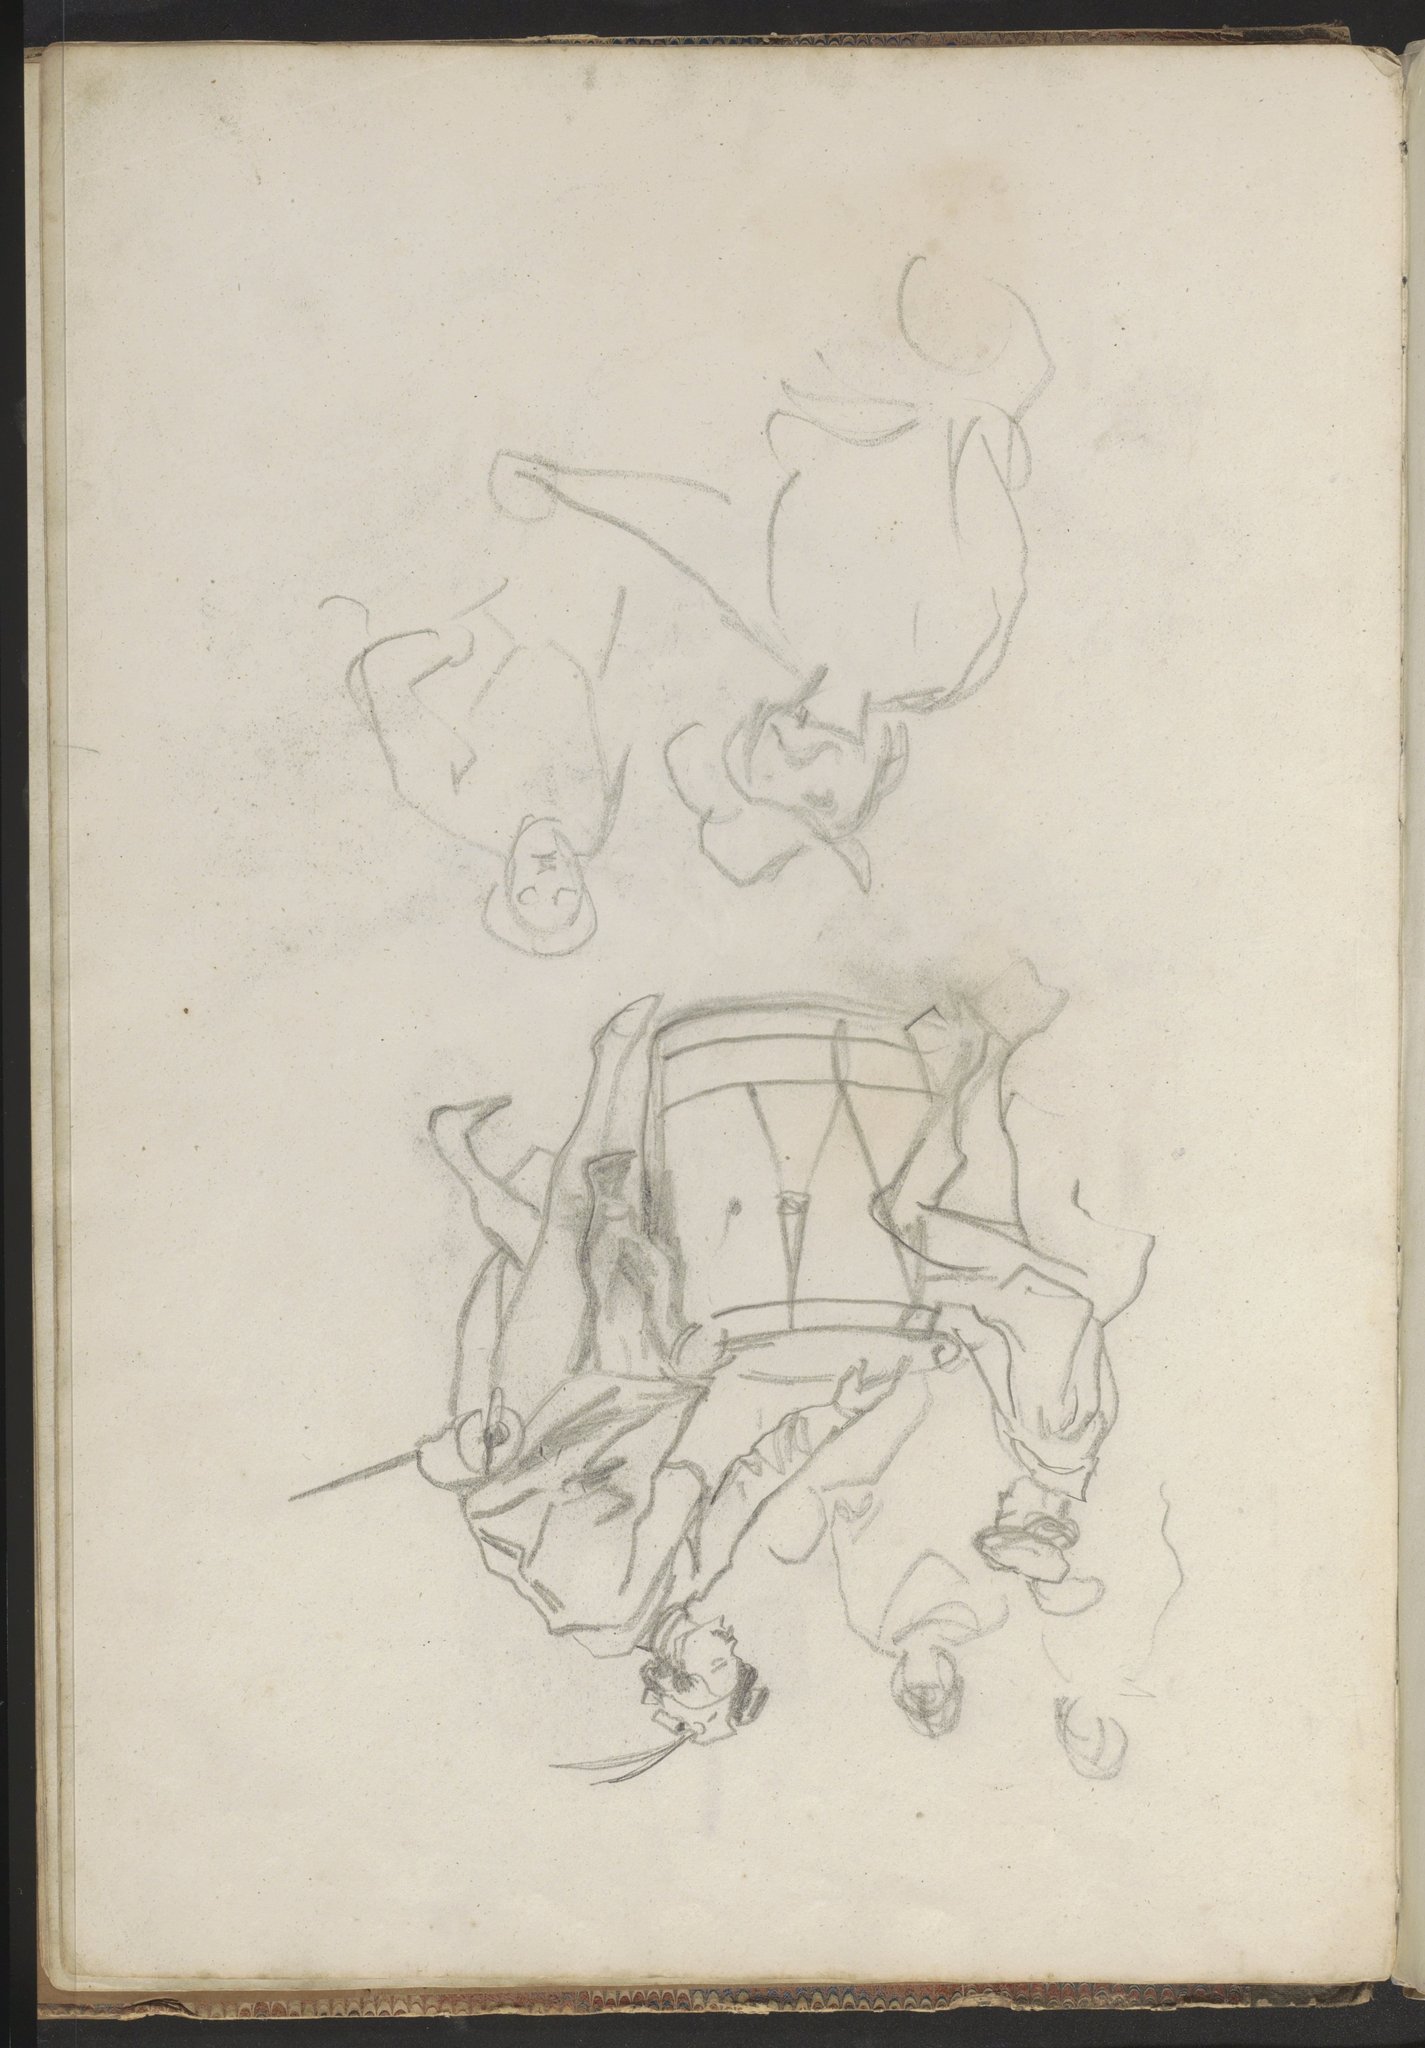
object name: sketchbook leaf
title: Studieblad met figuren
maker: johannes huybertus van hove bzn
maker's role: print maker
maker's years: 1827-1881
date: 1837-1881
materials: paper, pencil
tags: anatomy (non-medical), historical costume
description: Onder andere figuren in zeventiende-eeuws kostuum bij een tafel of ton. Blad 13 verso uit een schetsboek met 33 bladen en 10 losse tekeningen.